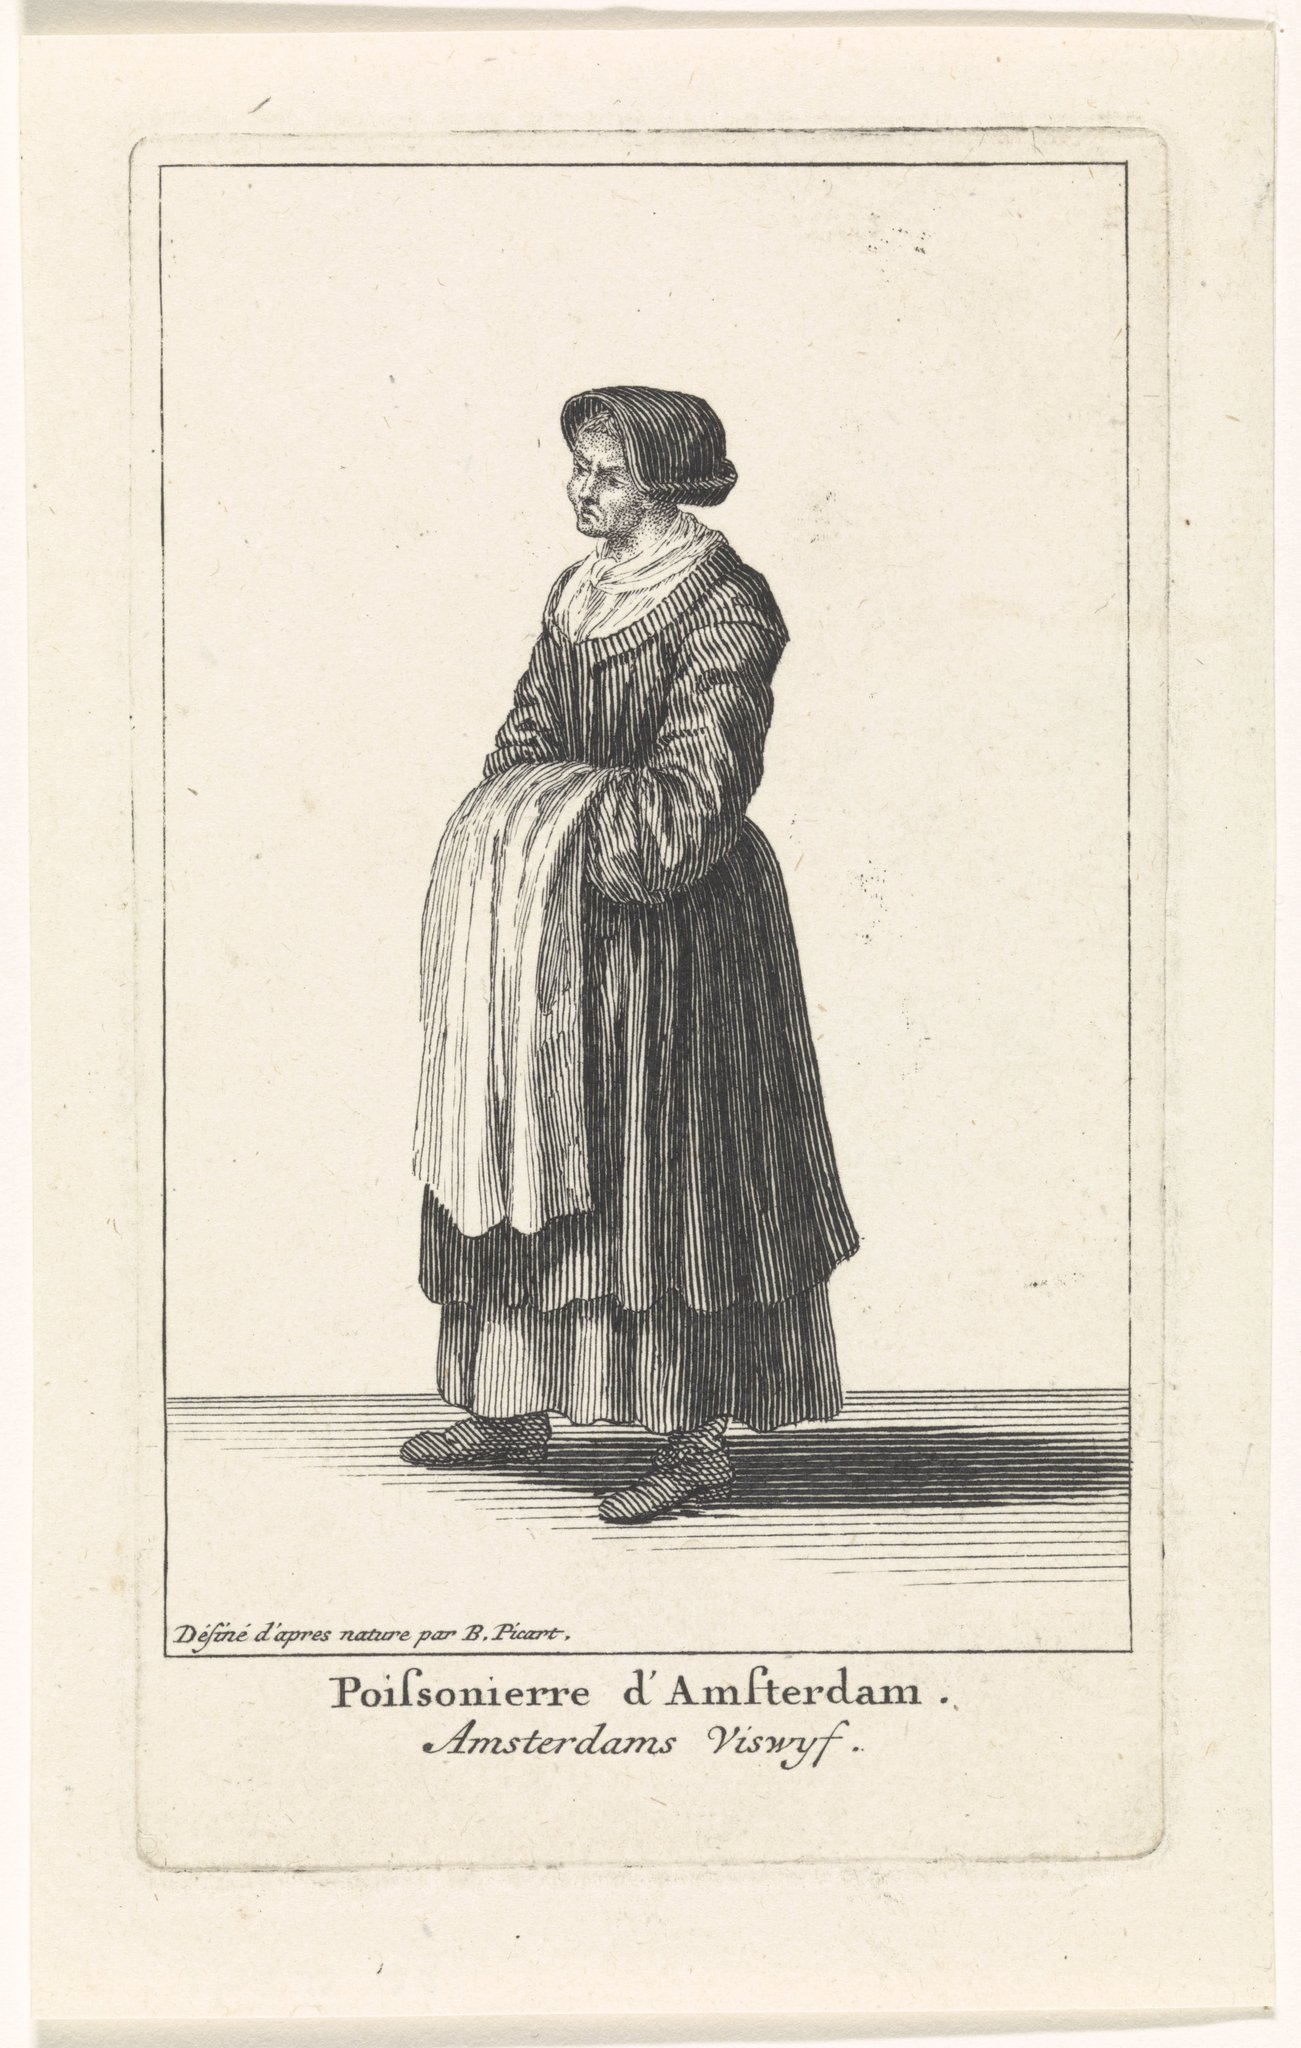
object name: costume print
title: Diverses modes Dessinées d'apres Nature (...)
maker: bernard picart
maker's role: draughtsman, print maker, publisher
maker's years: 1673-1733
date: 1728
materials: paper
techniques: engraving, etching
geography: amsterdam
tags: folk costume, regional costume, amsterdam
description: Prent waarschijnlijk ook opgenomen in: Diverses modes dessinées d'après Nature. Amsterdam: Bernard Picart, 1728.